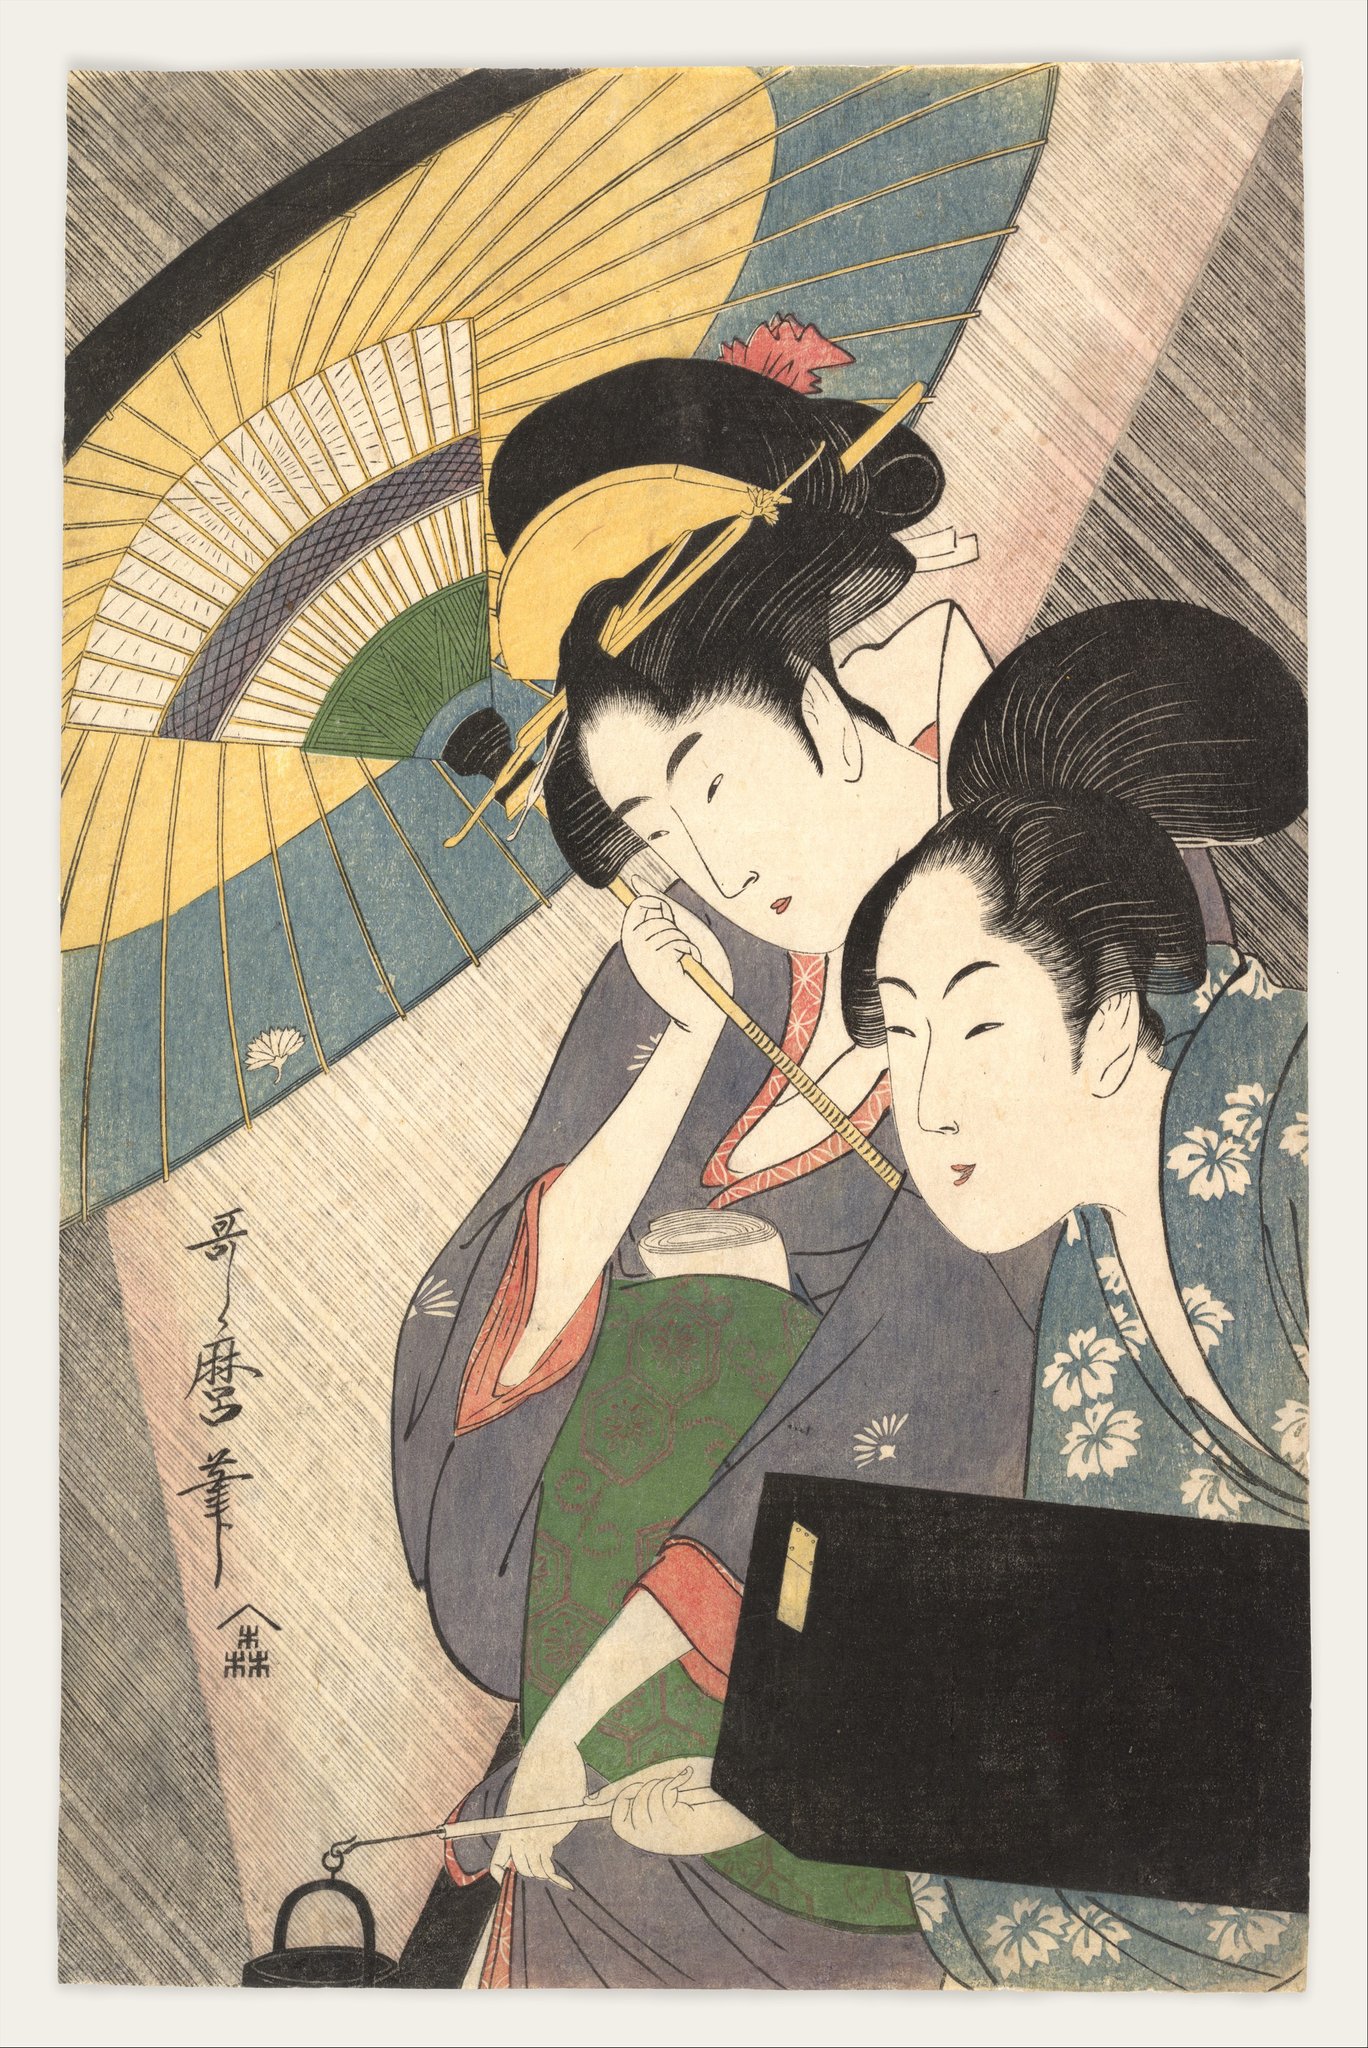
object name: print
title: Geisha and Attendant on a Rainy Night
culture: japanese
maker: kitagawa utamaro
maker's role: artist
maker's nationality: japanese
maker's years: 1754-1806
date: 1797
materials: ink, paper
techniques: woodblock print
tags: women,servants